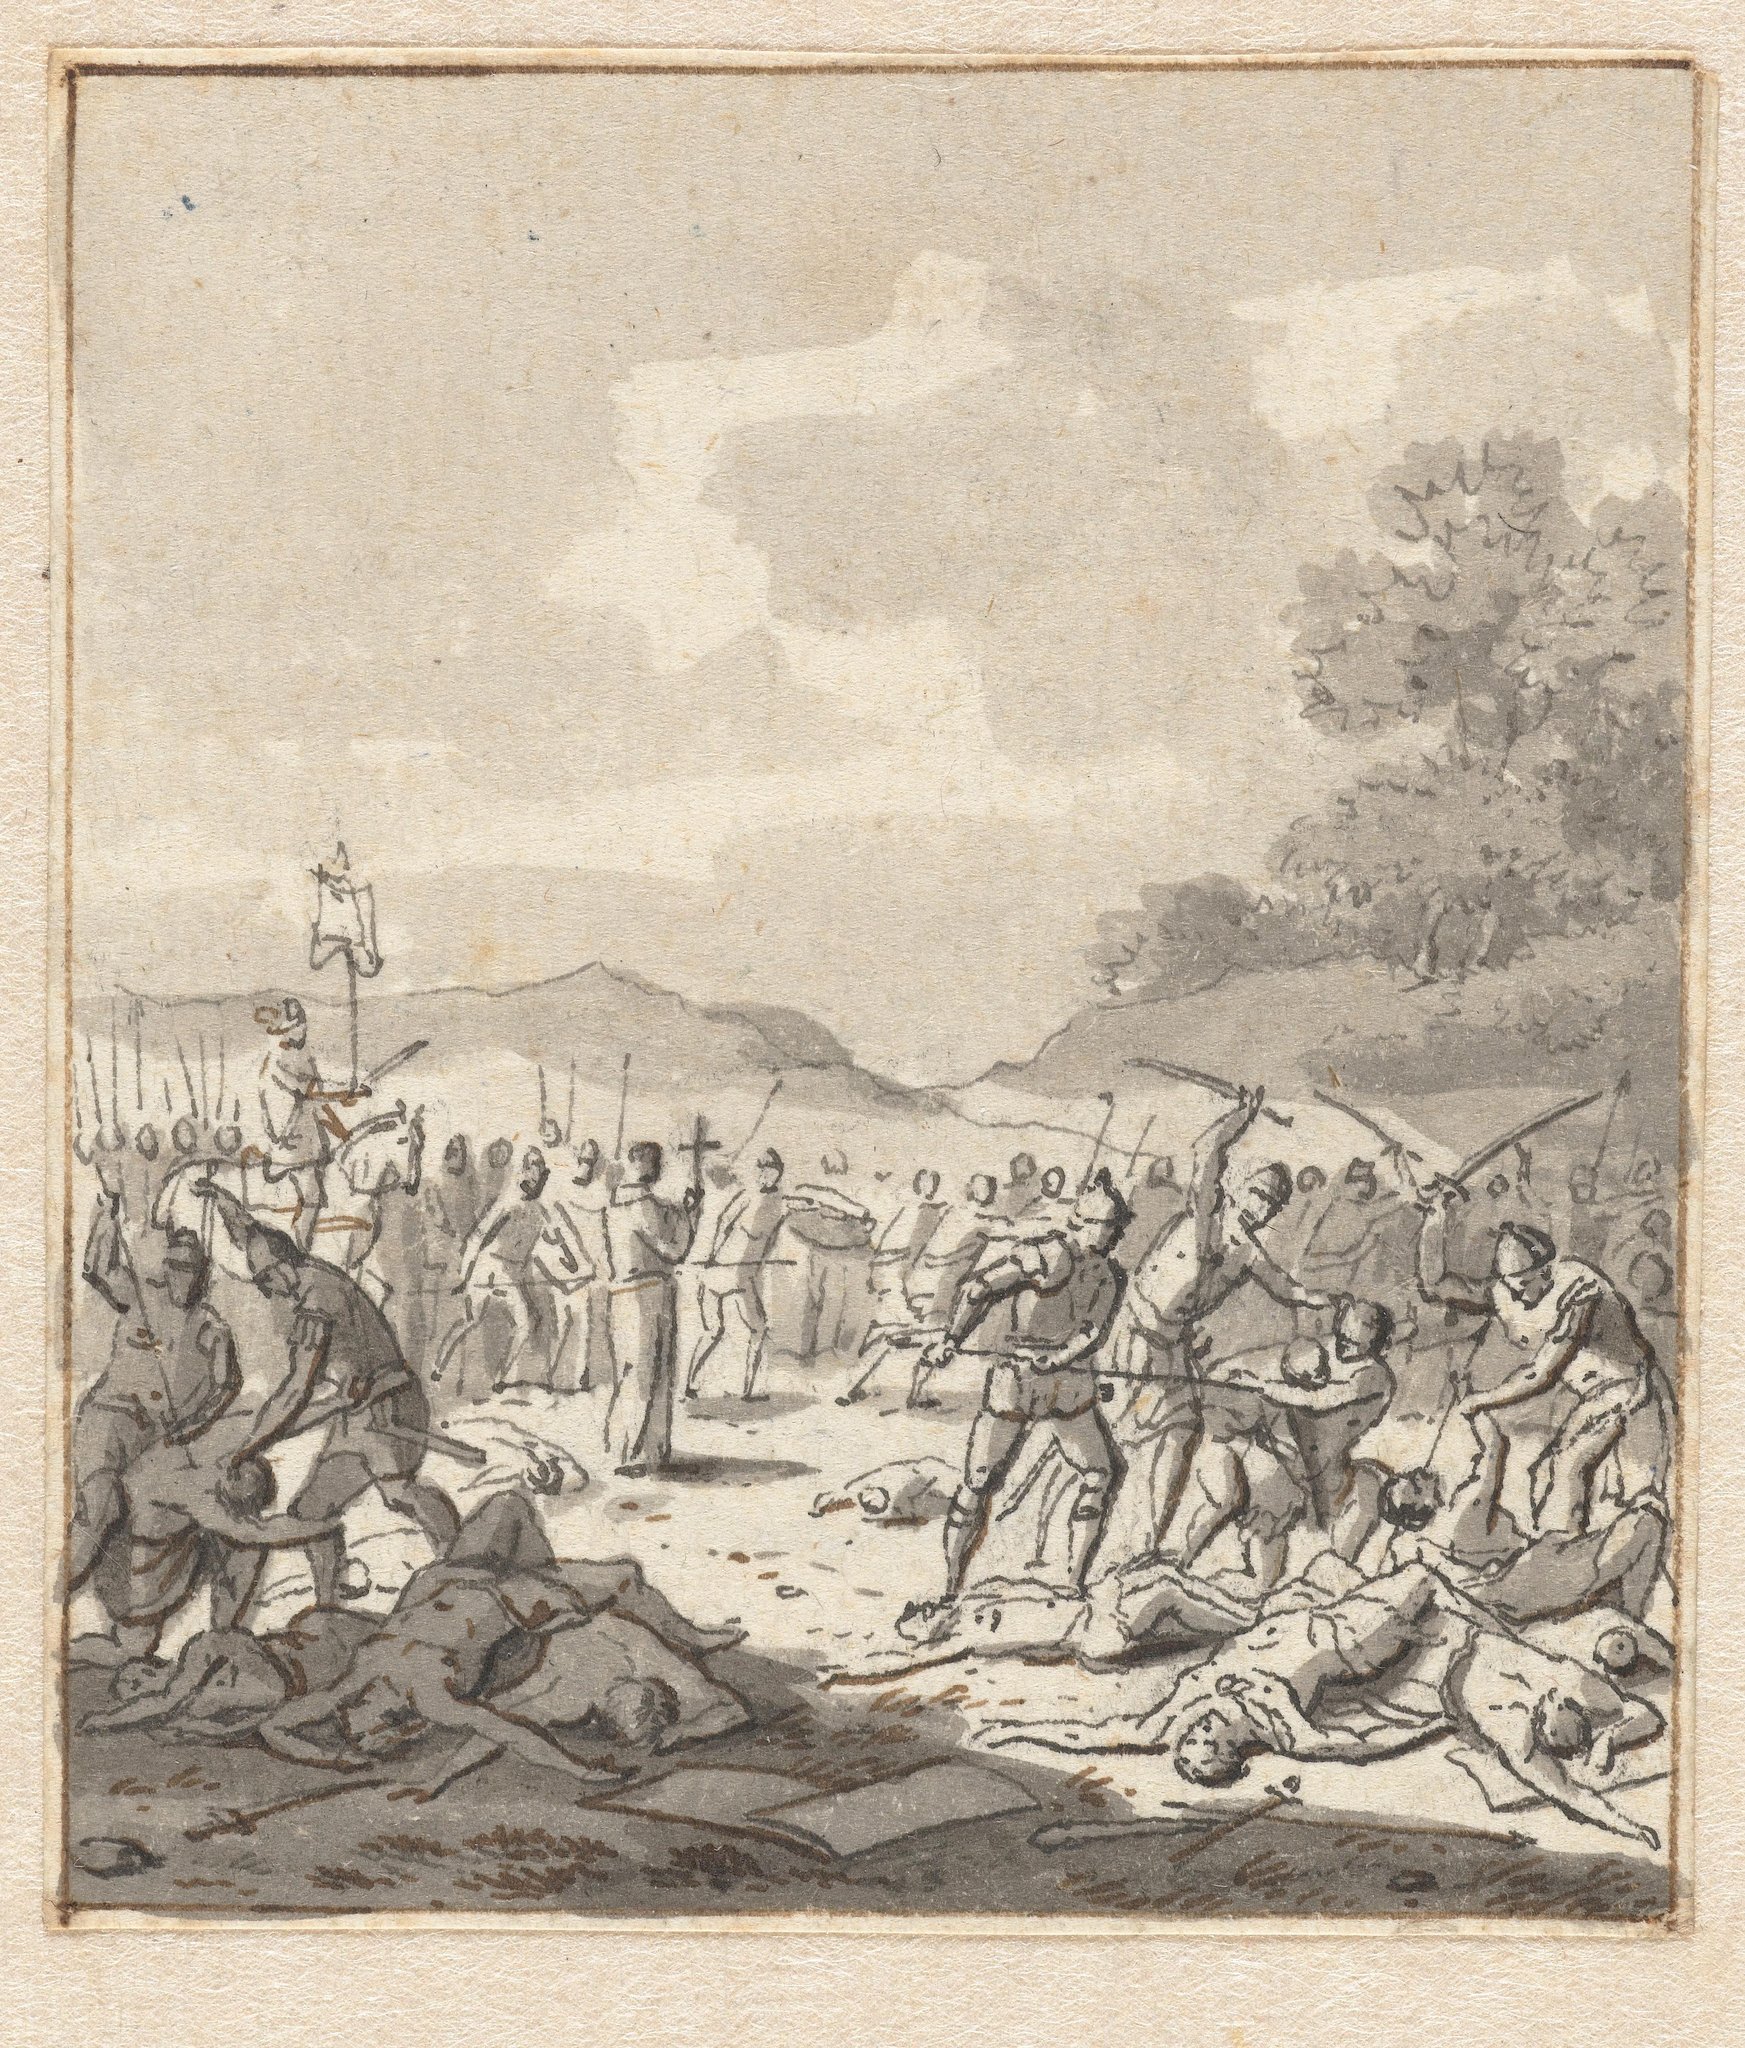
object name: design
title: In 't jaar 496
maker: Anonymous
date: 1789-1810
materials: ink, paper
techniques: brush, pen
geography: netherlands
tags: battle (+ land forces)